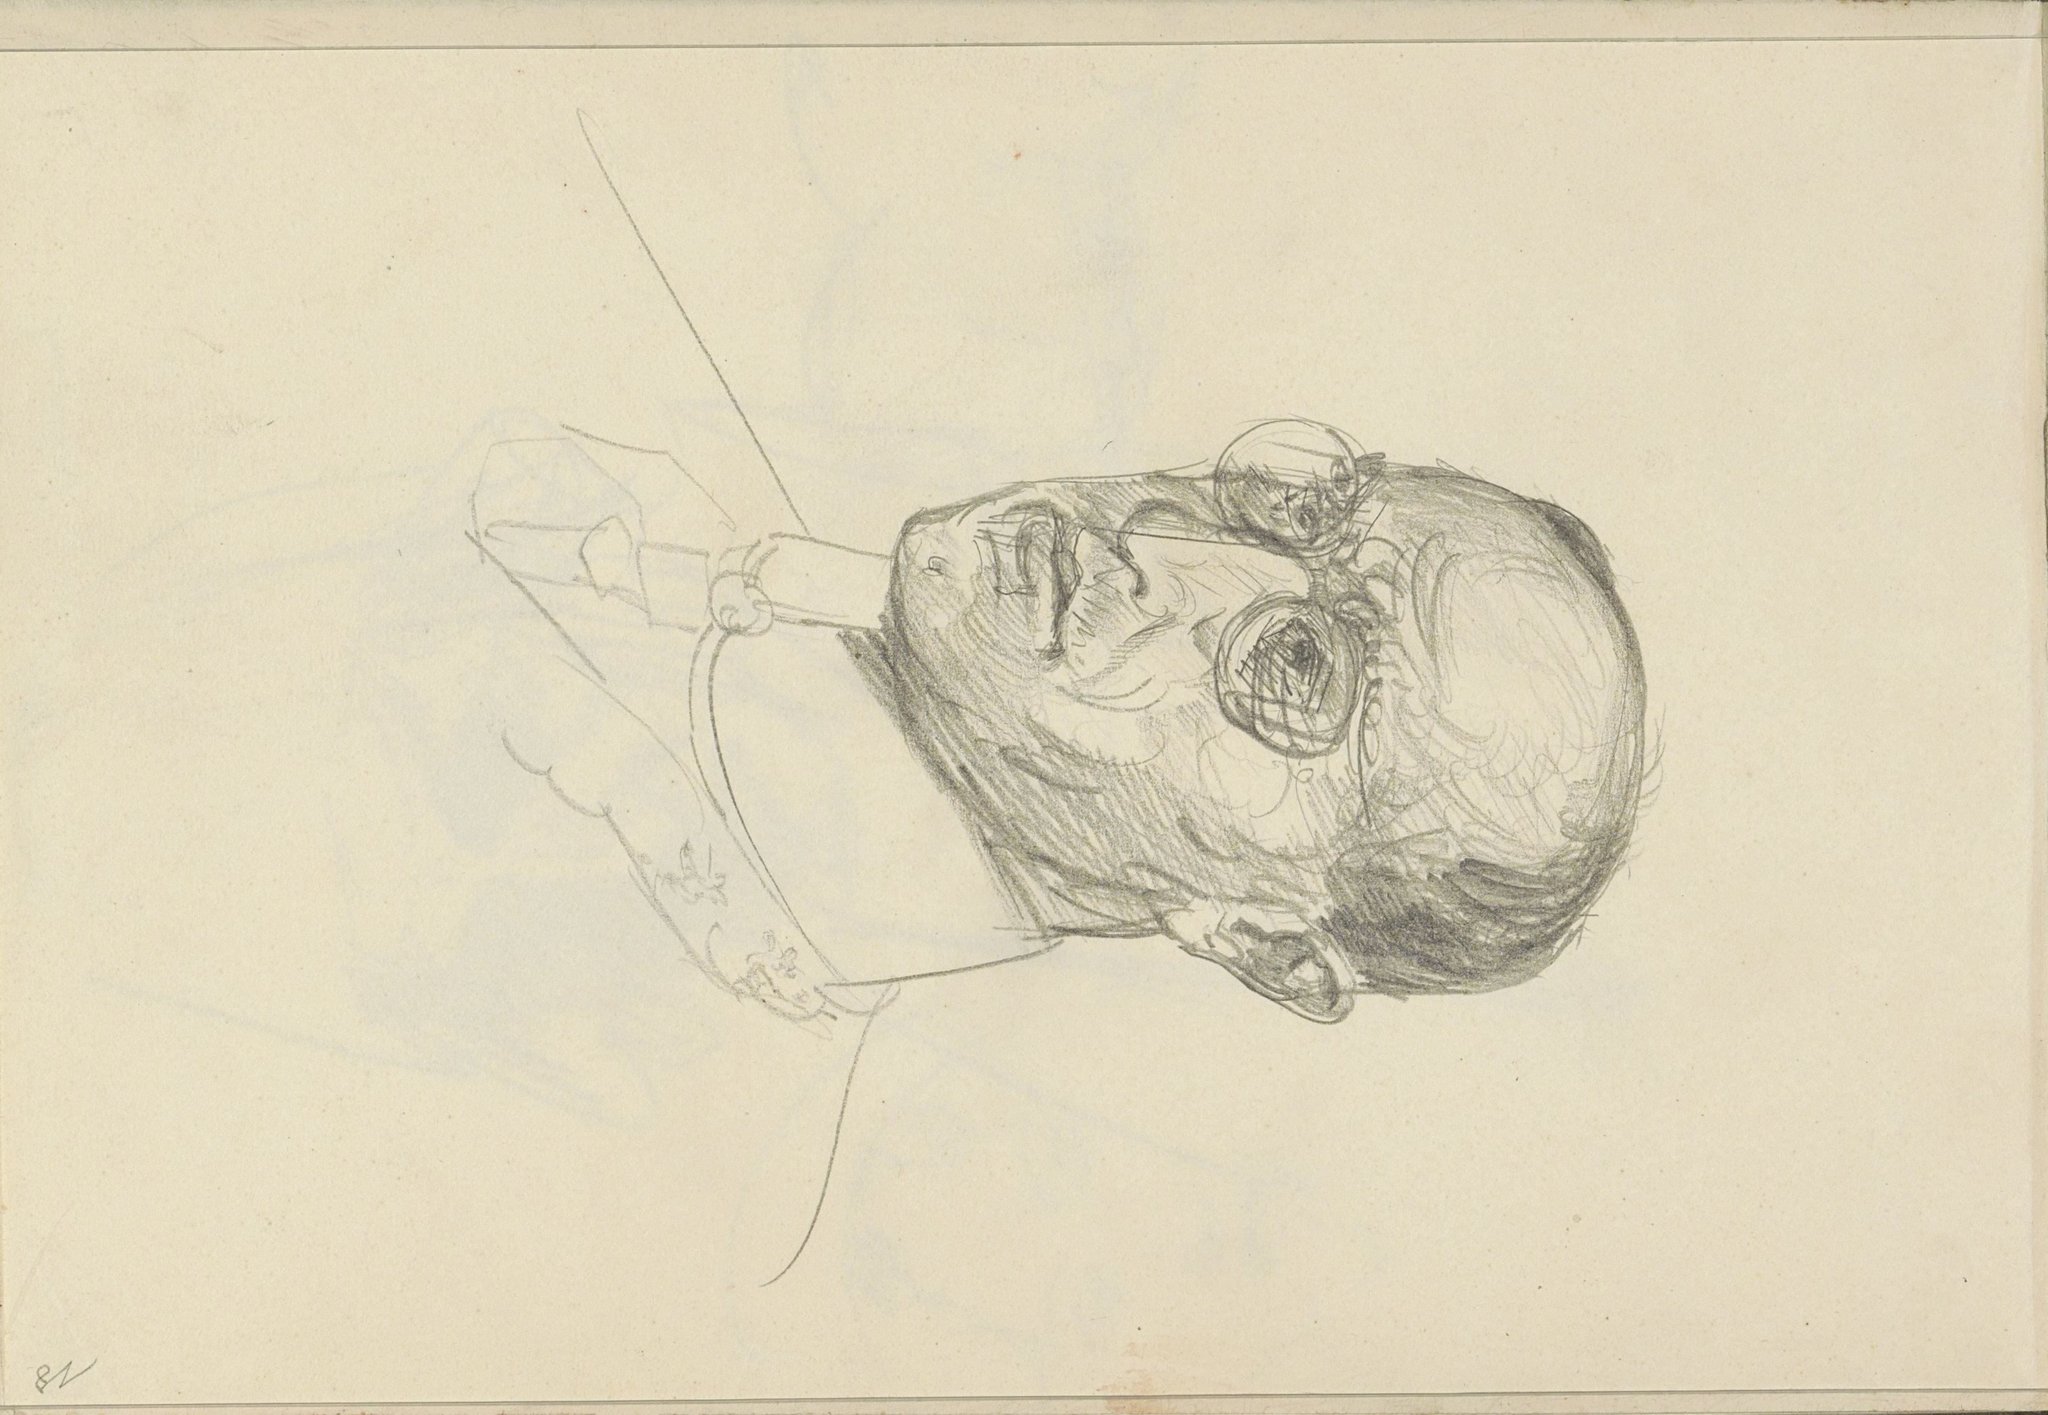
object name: sketchbook leaf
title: Portret van een onbekende man met bril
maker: isaac israels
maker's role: draughtsman, painter, print maker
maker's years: 1865-1934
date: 1875-1934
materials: paper, pencil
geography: the hague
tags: eyeglasses, spectacles, anonymous historical person portrayed alone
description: Blad 17 verso uit schetsboek XXVIII met 17 bladen.